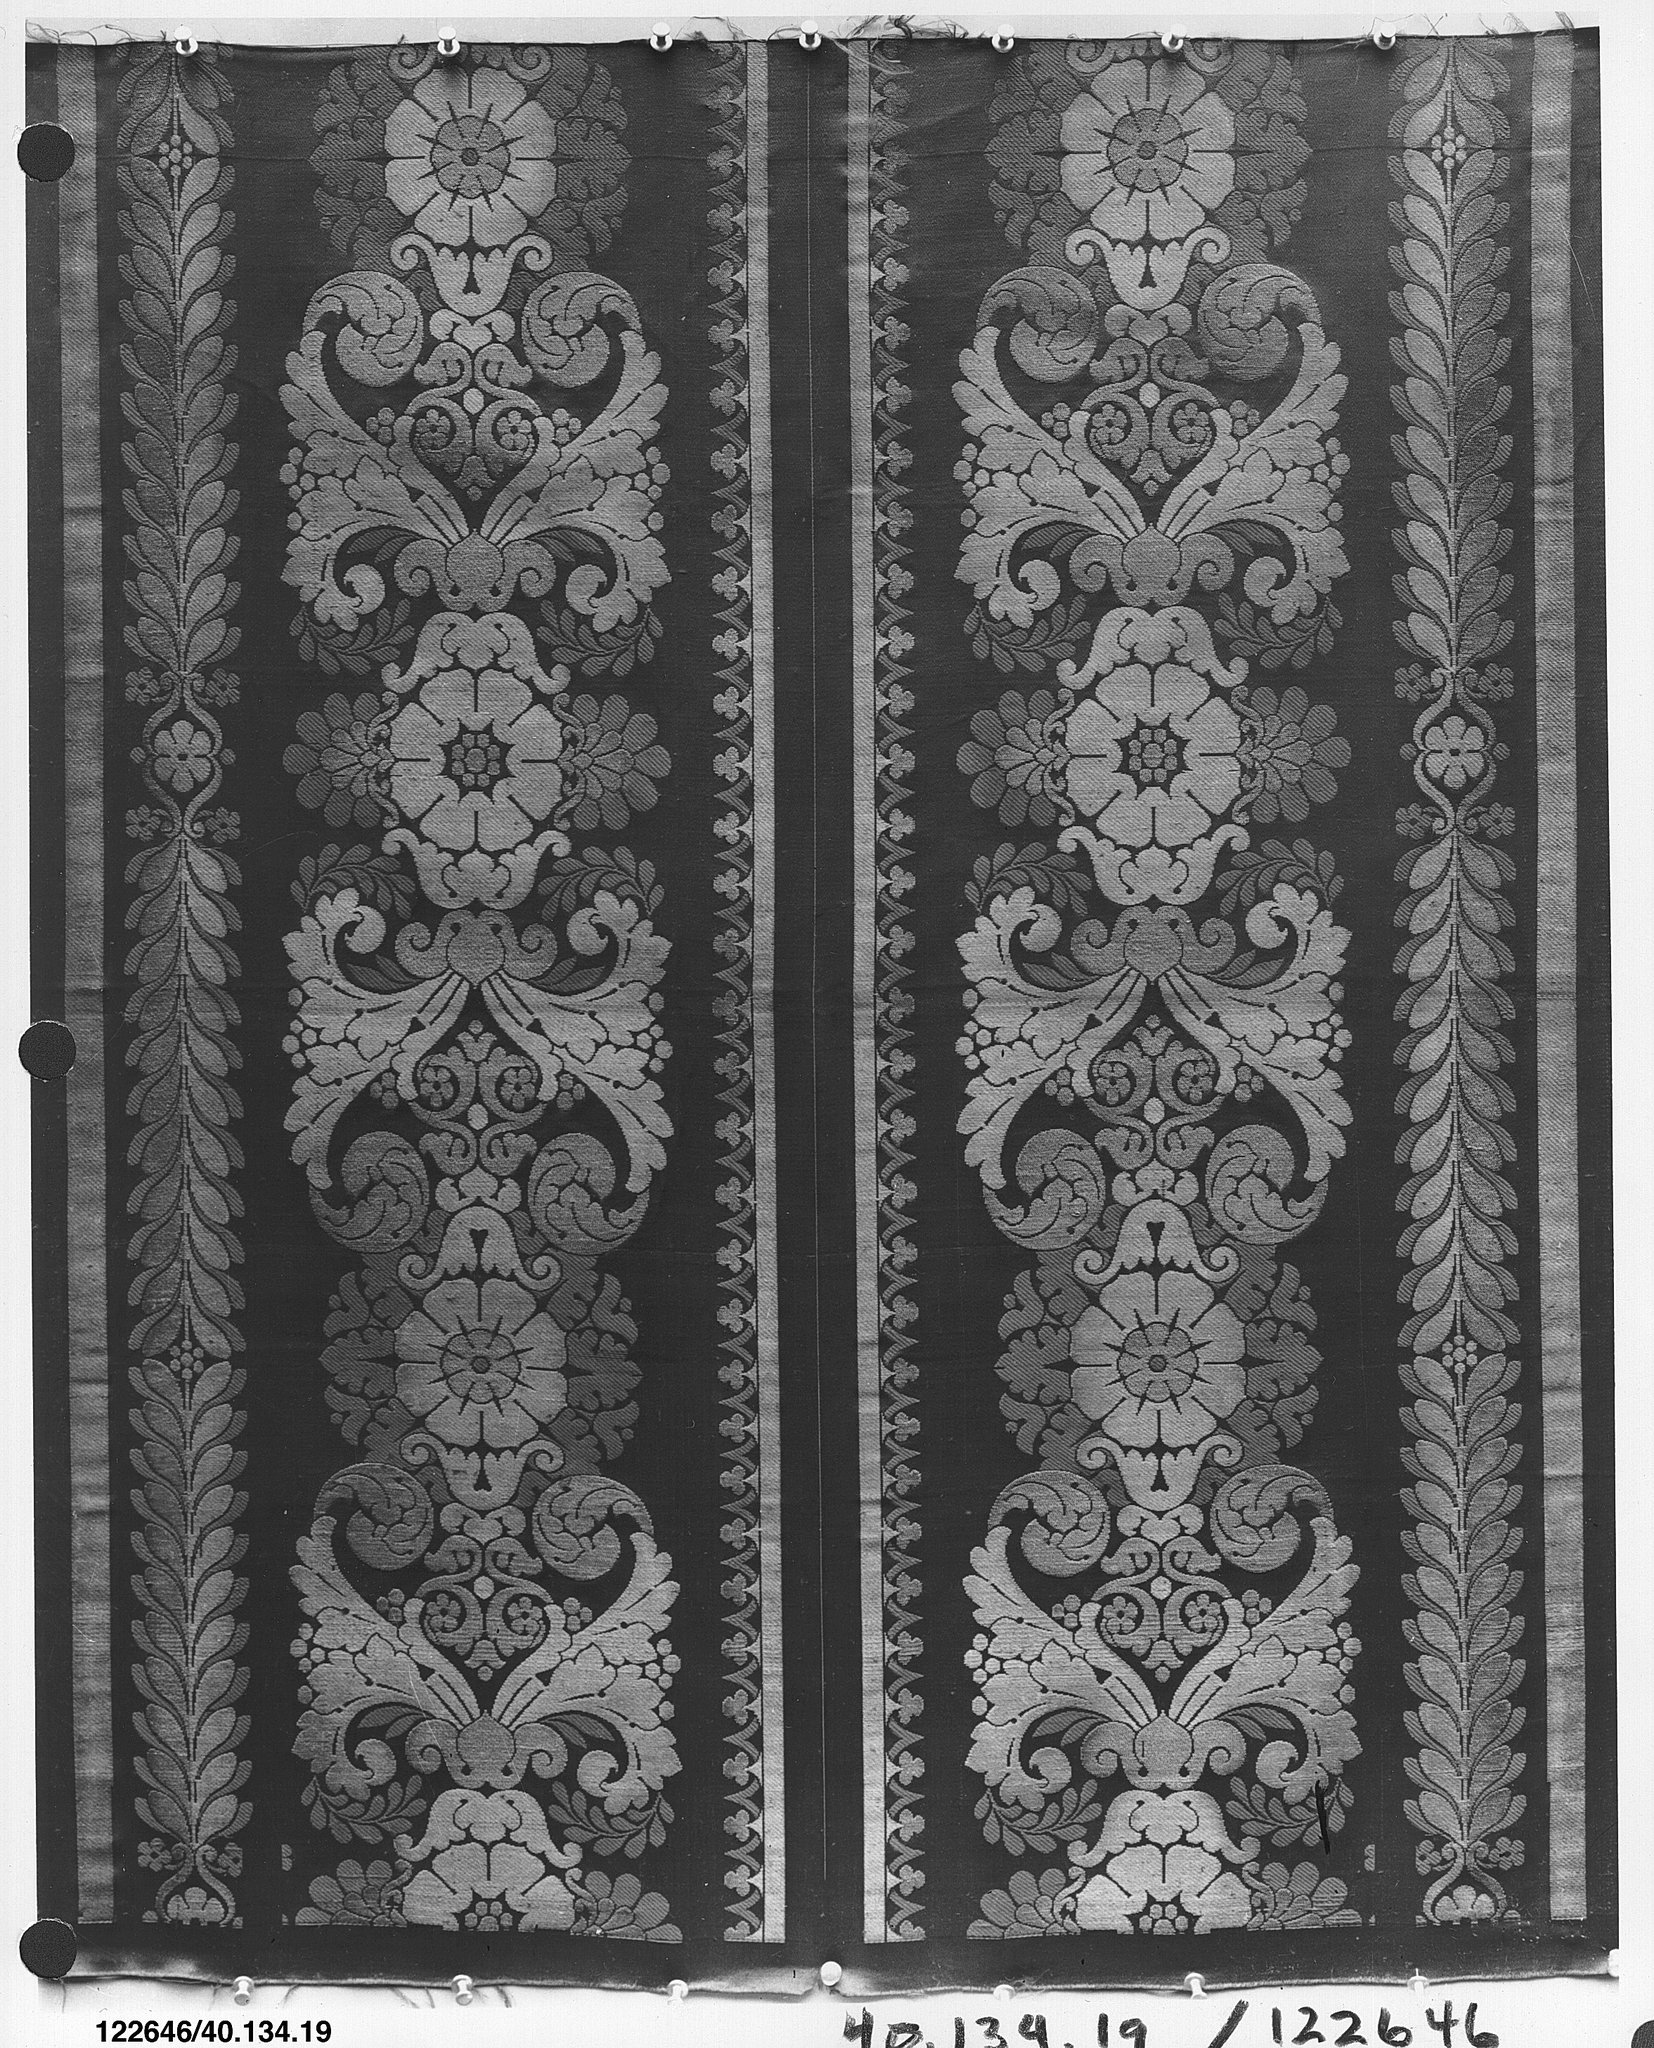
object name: border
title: Borders (2)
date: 1815-1830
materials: metal thread, silk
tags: flowers